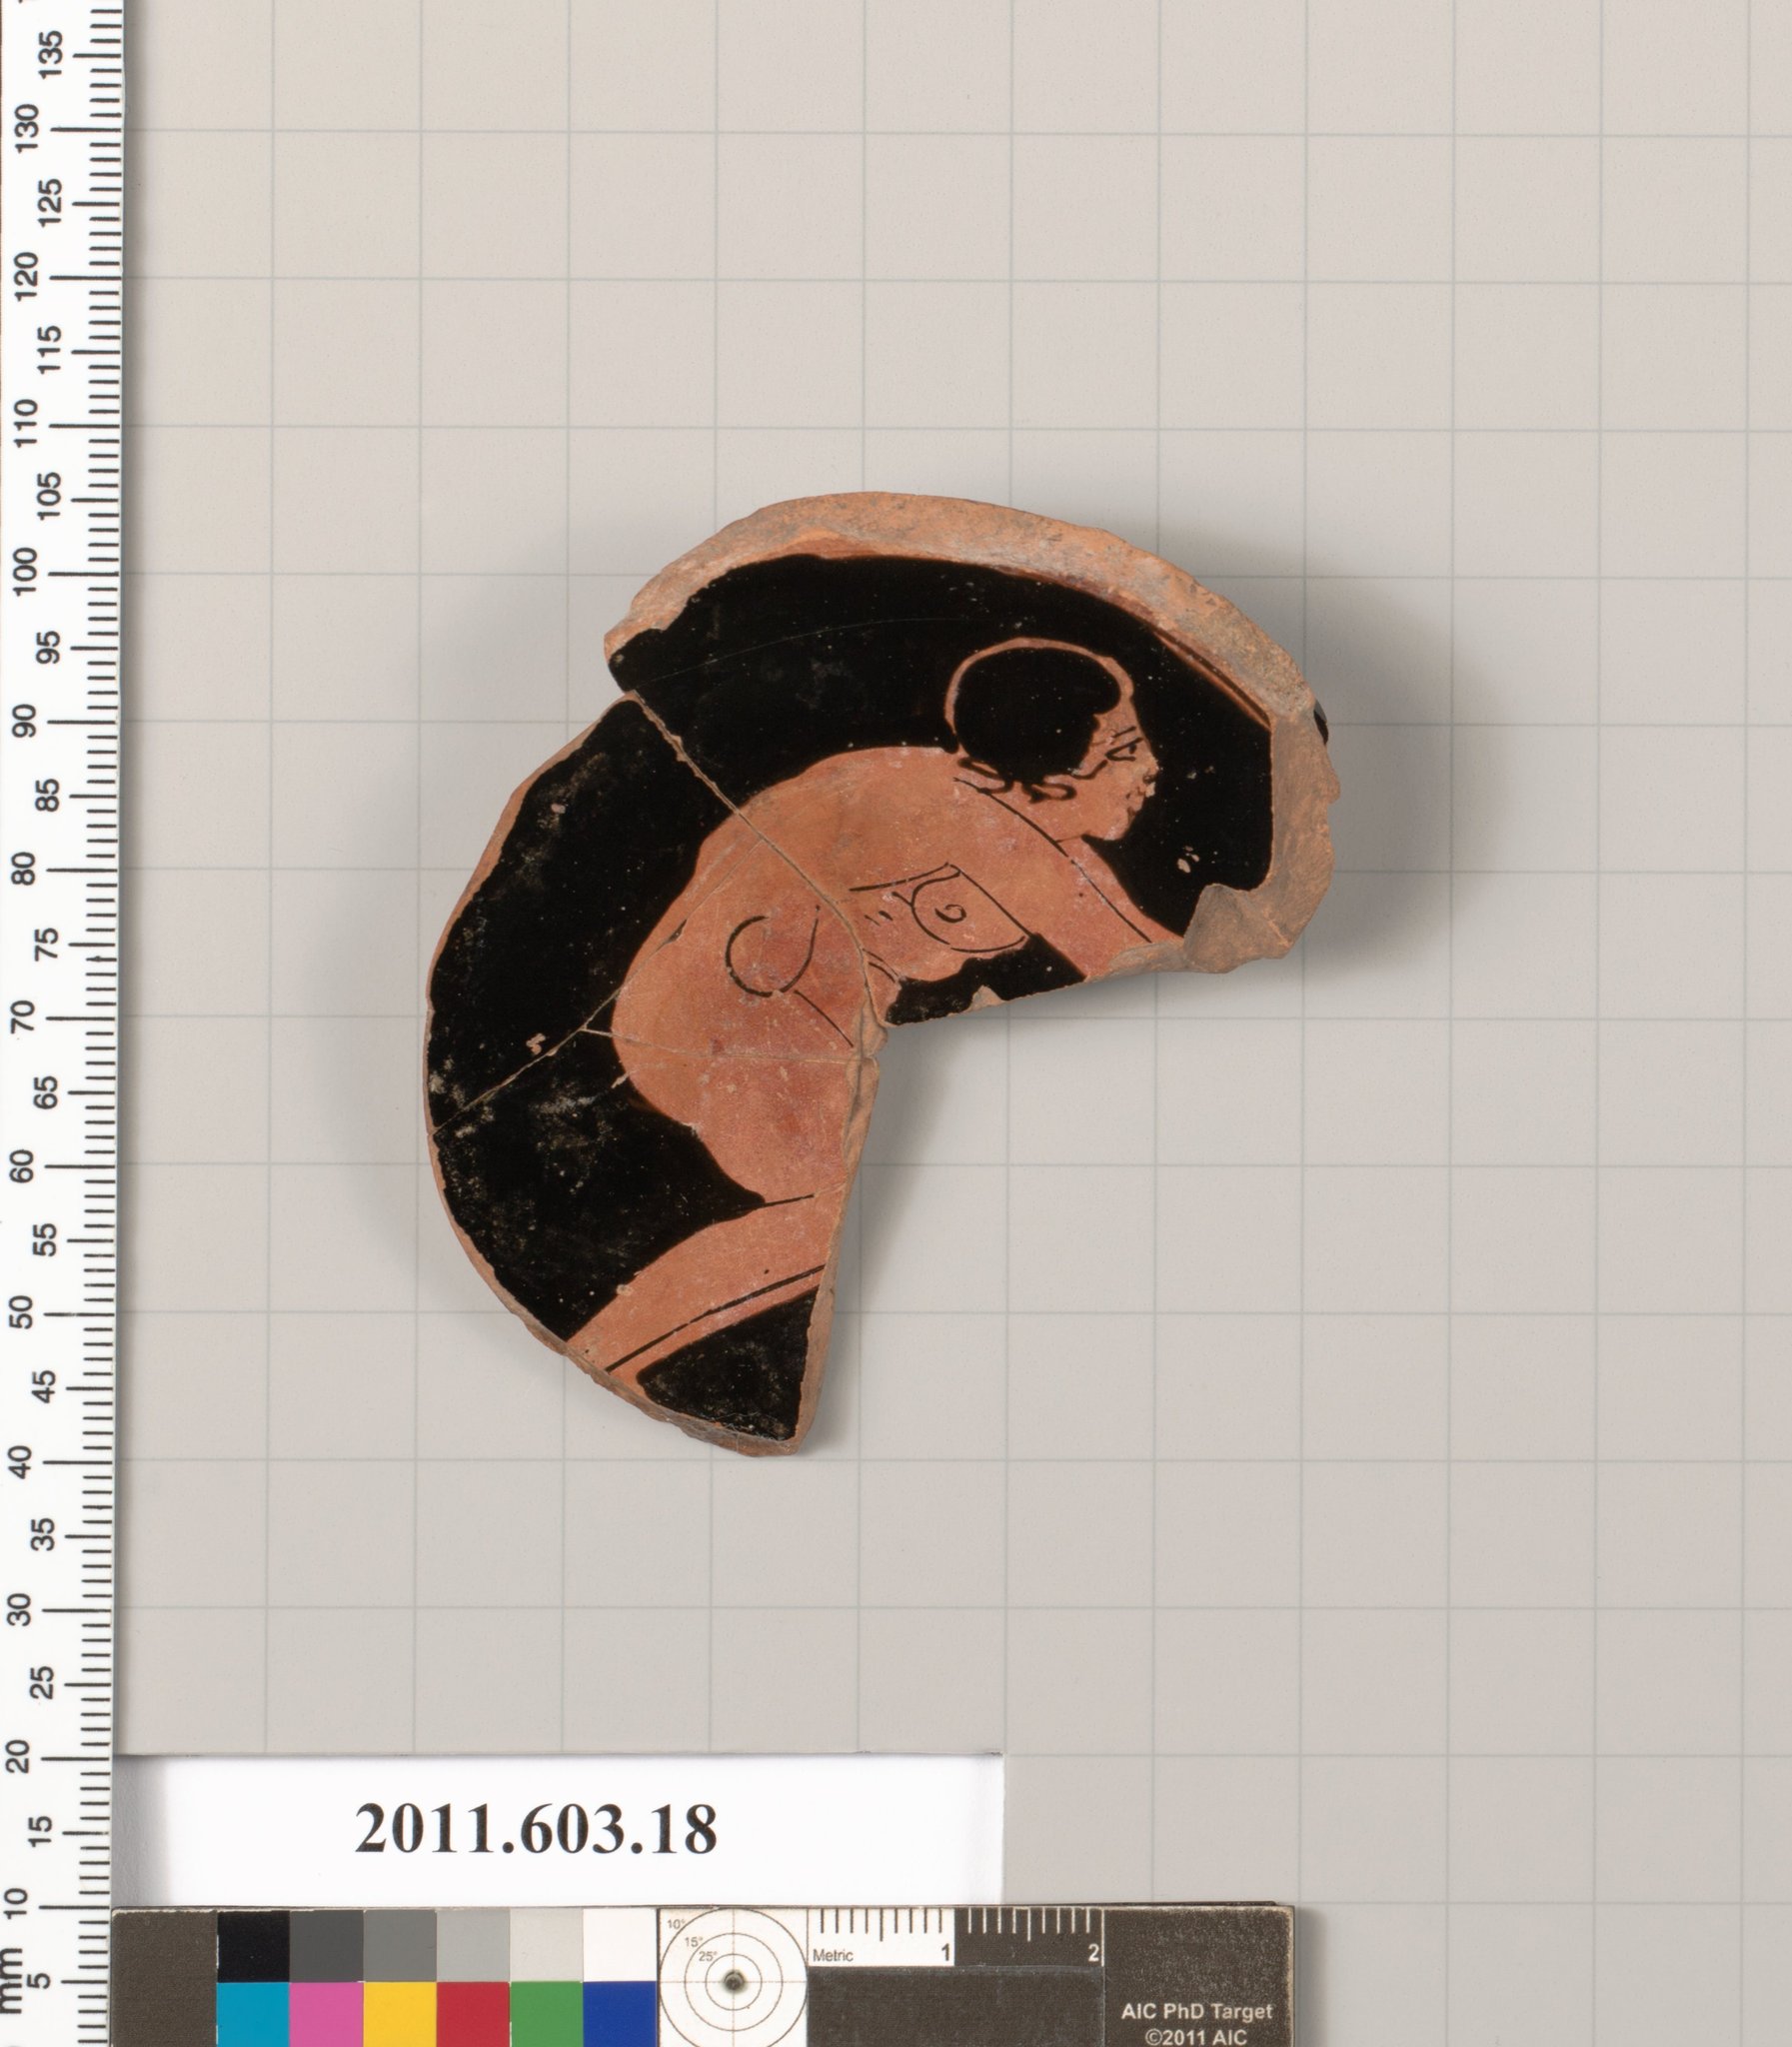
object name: kylix fragment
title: Fragment of a terracotta stemless kylix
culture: greek, attic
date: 450-426 BCE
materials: terracotta